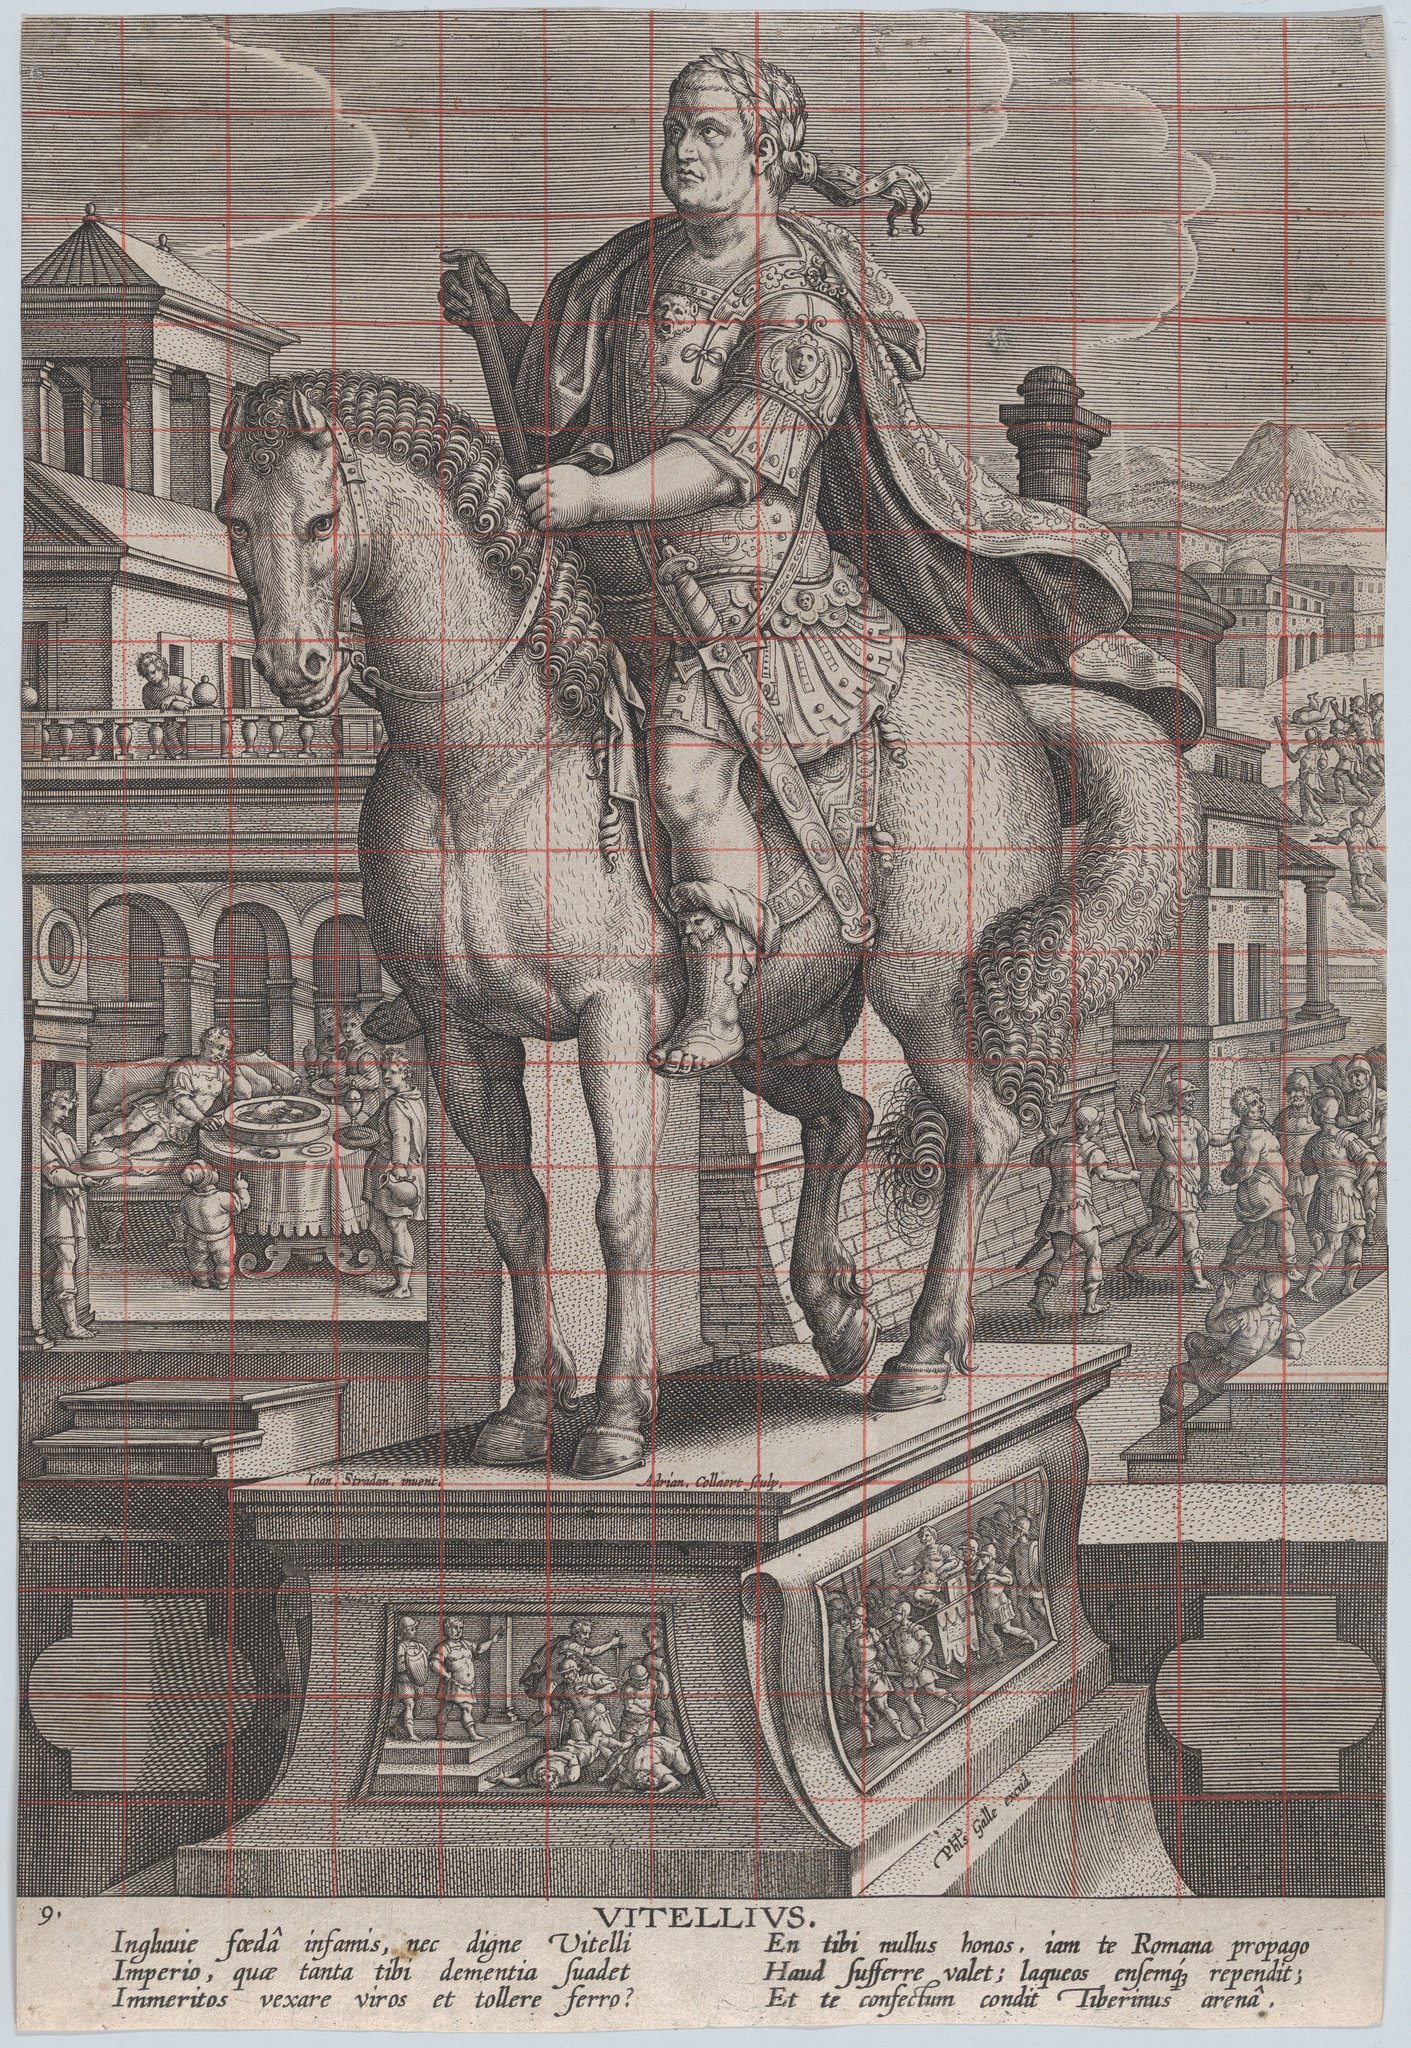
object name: print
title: Plate 9: equestrian statue of Vitellius, seen three-quarters to the left, with his death scene in the background at right, his body being thrown into the Tiber at upper right, from 'Roman Emperors on Horseback'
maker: adriaen collaert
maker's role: artist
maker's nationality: netherlandish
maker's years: 1560-1618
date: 1587-1589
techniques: engraving, drawing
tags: sculpture,men,horses